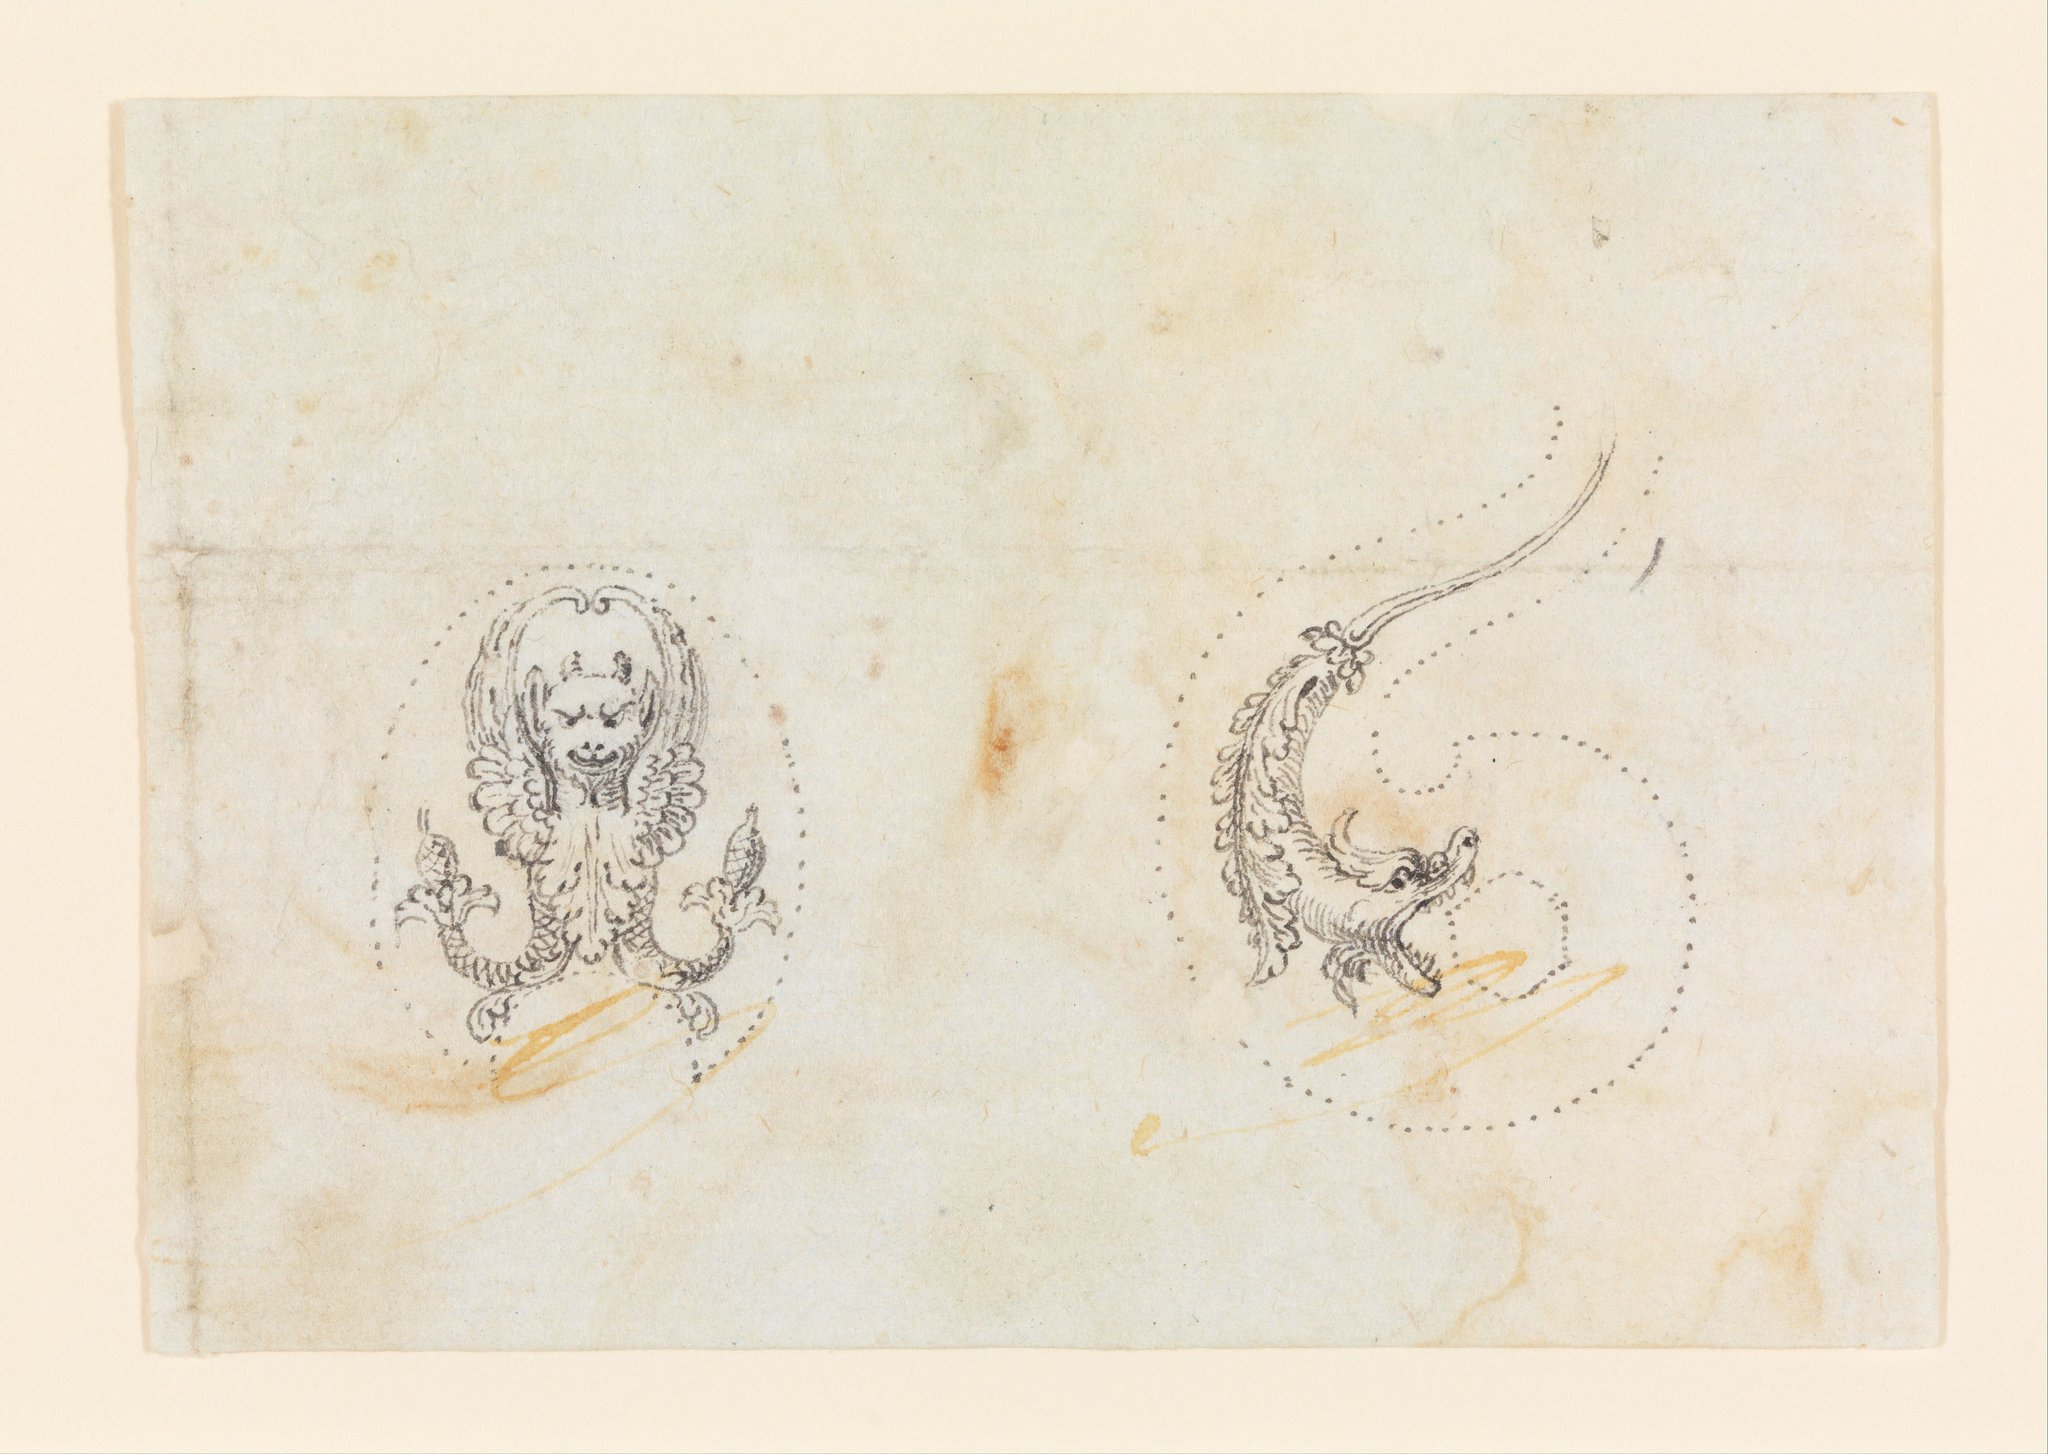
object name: drawing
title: Designs for the Decoration of the Jaw and Profile of the Cock of a Firearm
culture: french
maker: nicolas noël boutet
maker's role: designer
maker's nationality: french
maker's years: 1761-1833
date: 1795-1805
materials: ink, paper, pencil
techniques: wash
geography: france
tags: ornament